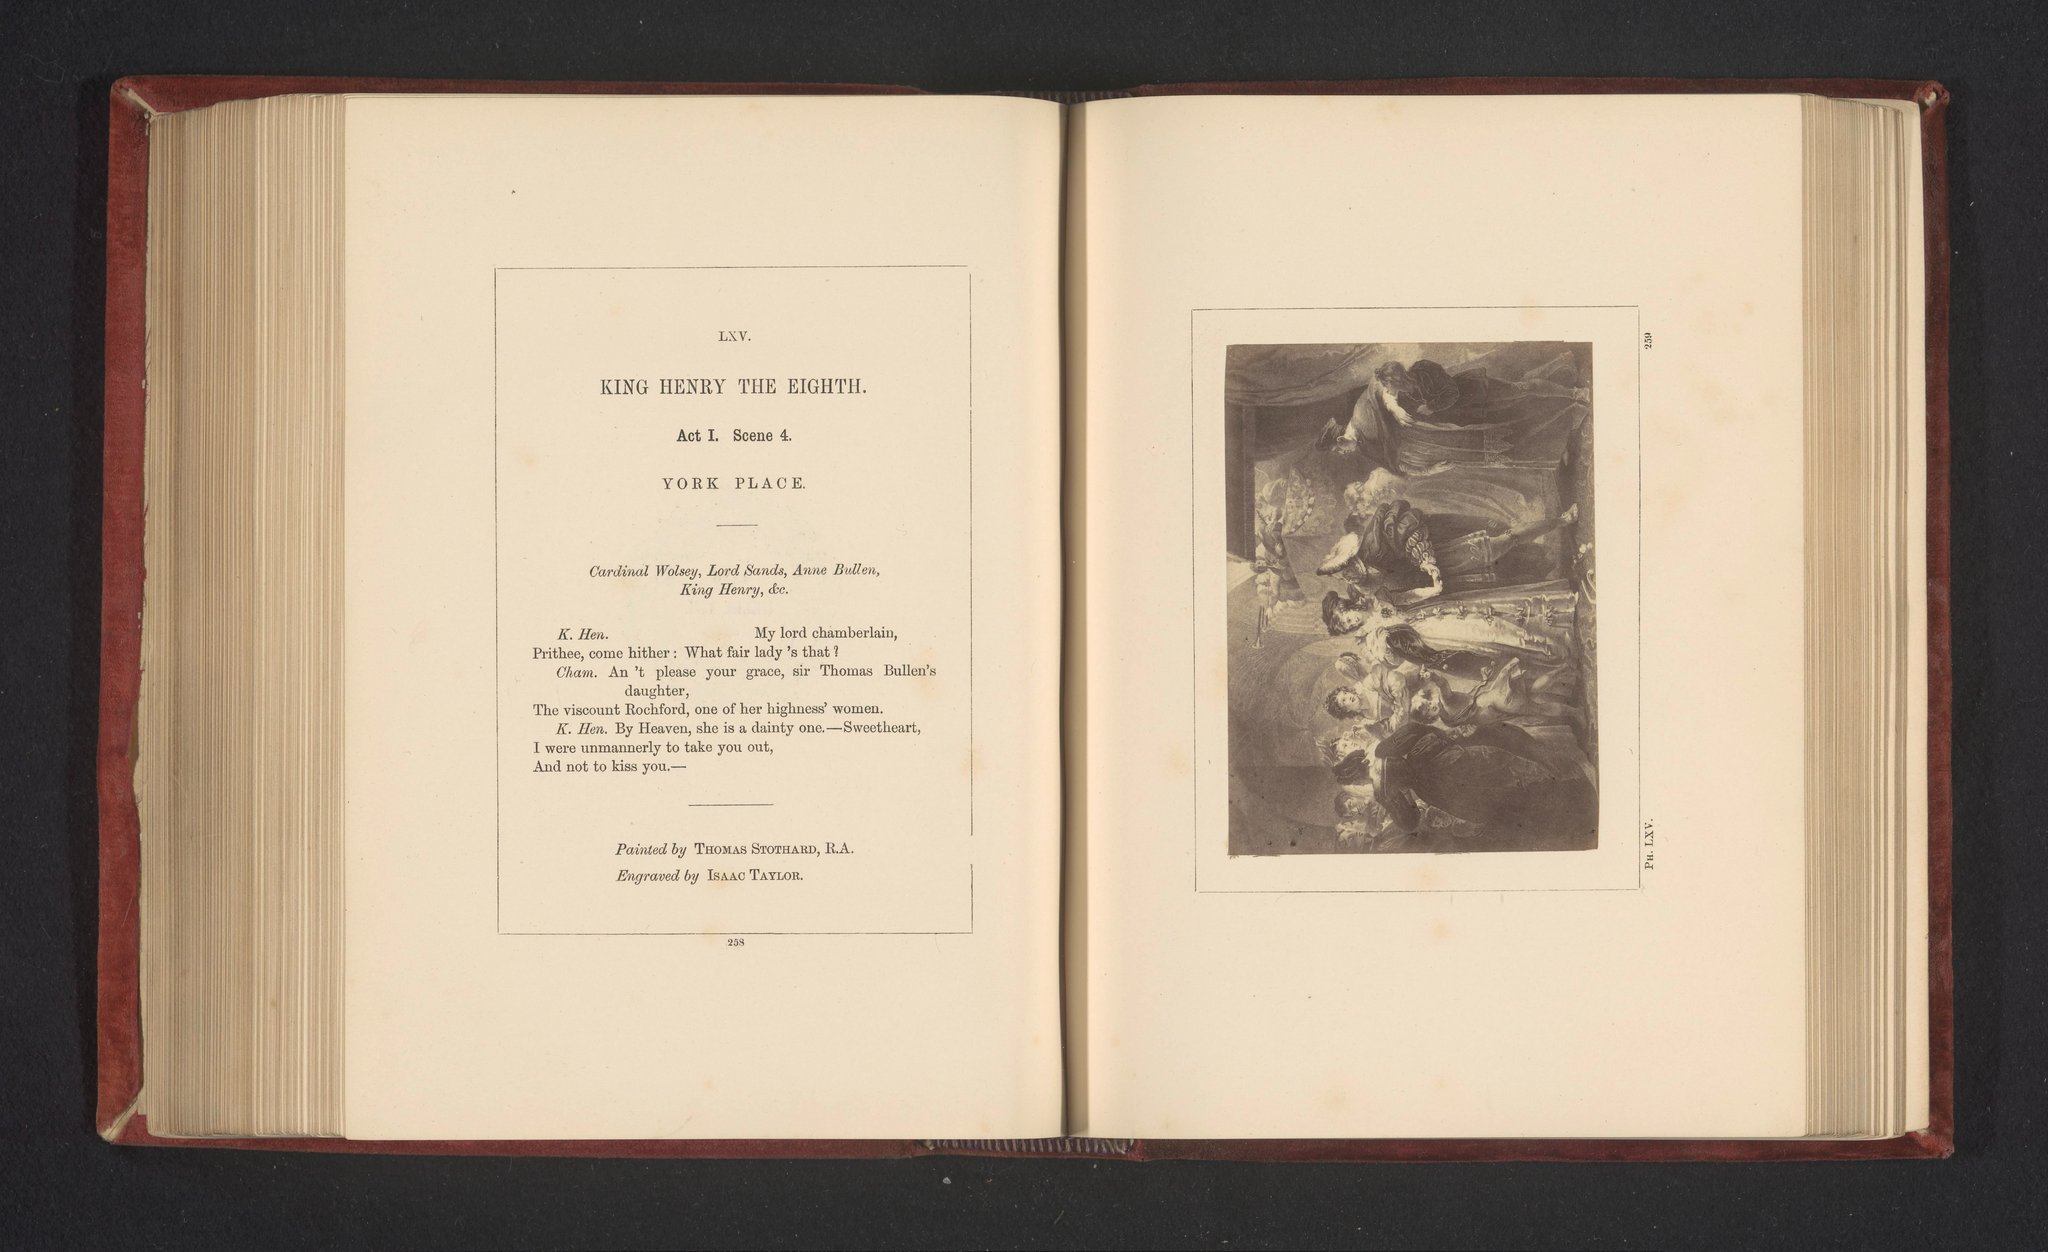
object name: photograph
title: Fotoreproductie van een prent naar een schilderij door Thomas Stothard, voorstellend een scene uit Hendrik VIII door William Shakespeare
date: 1854-1864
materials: photographic support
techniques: albumen print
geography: london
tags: specific works of literature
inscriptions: number: ‘Ph. LXV. 259’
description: Te zien is akte I, scene 4 met Koning Hendrik VIII van Engeland, kardinaal Thomas Wolsey en Anne Boleyn.